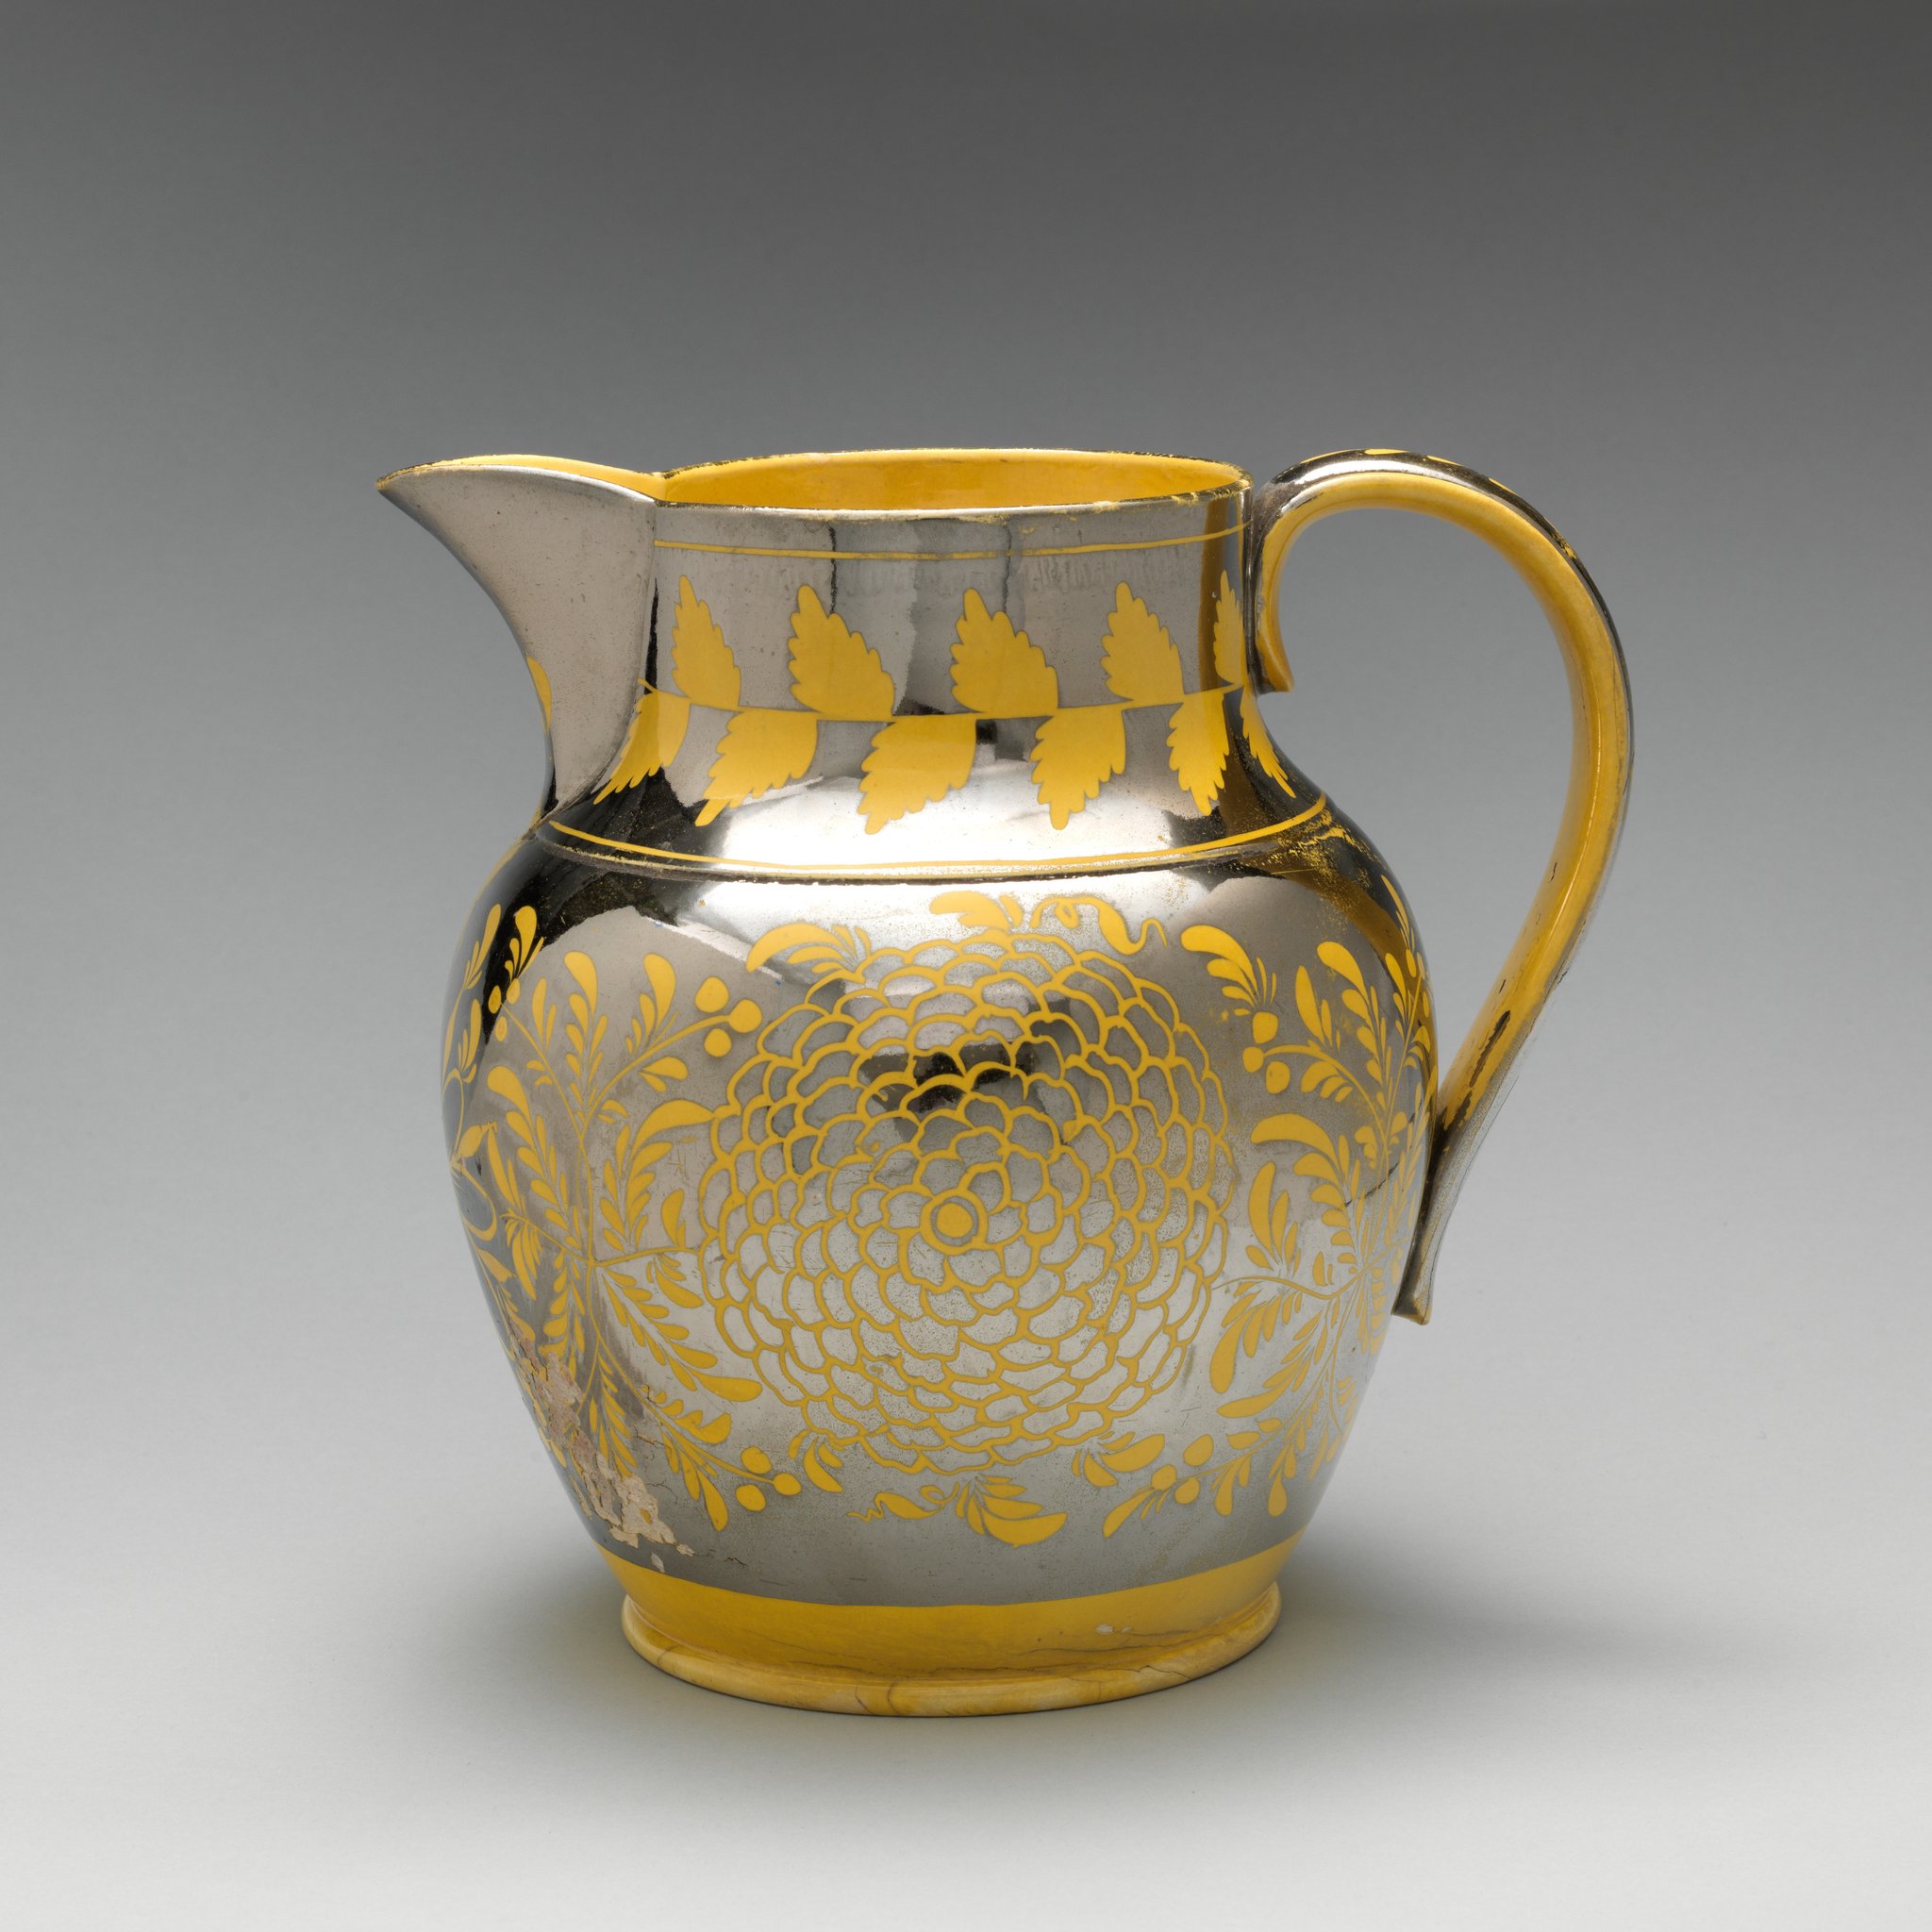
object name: jug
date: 1815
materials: earthenware